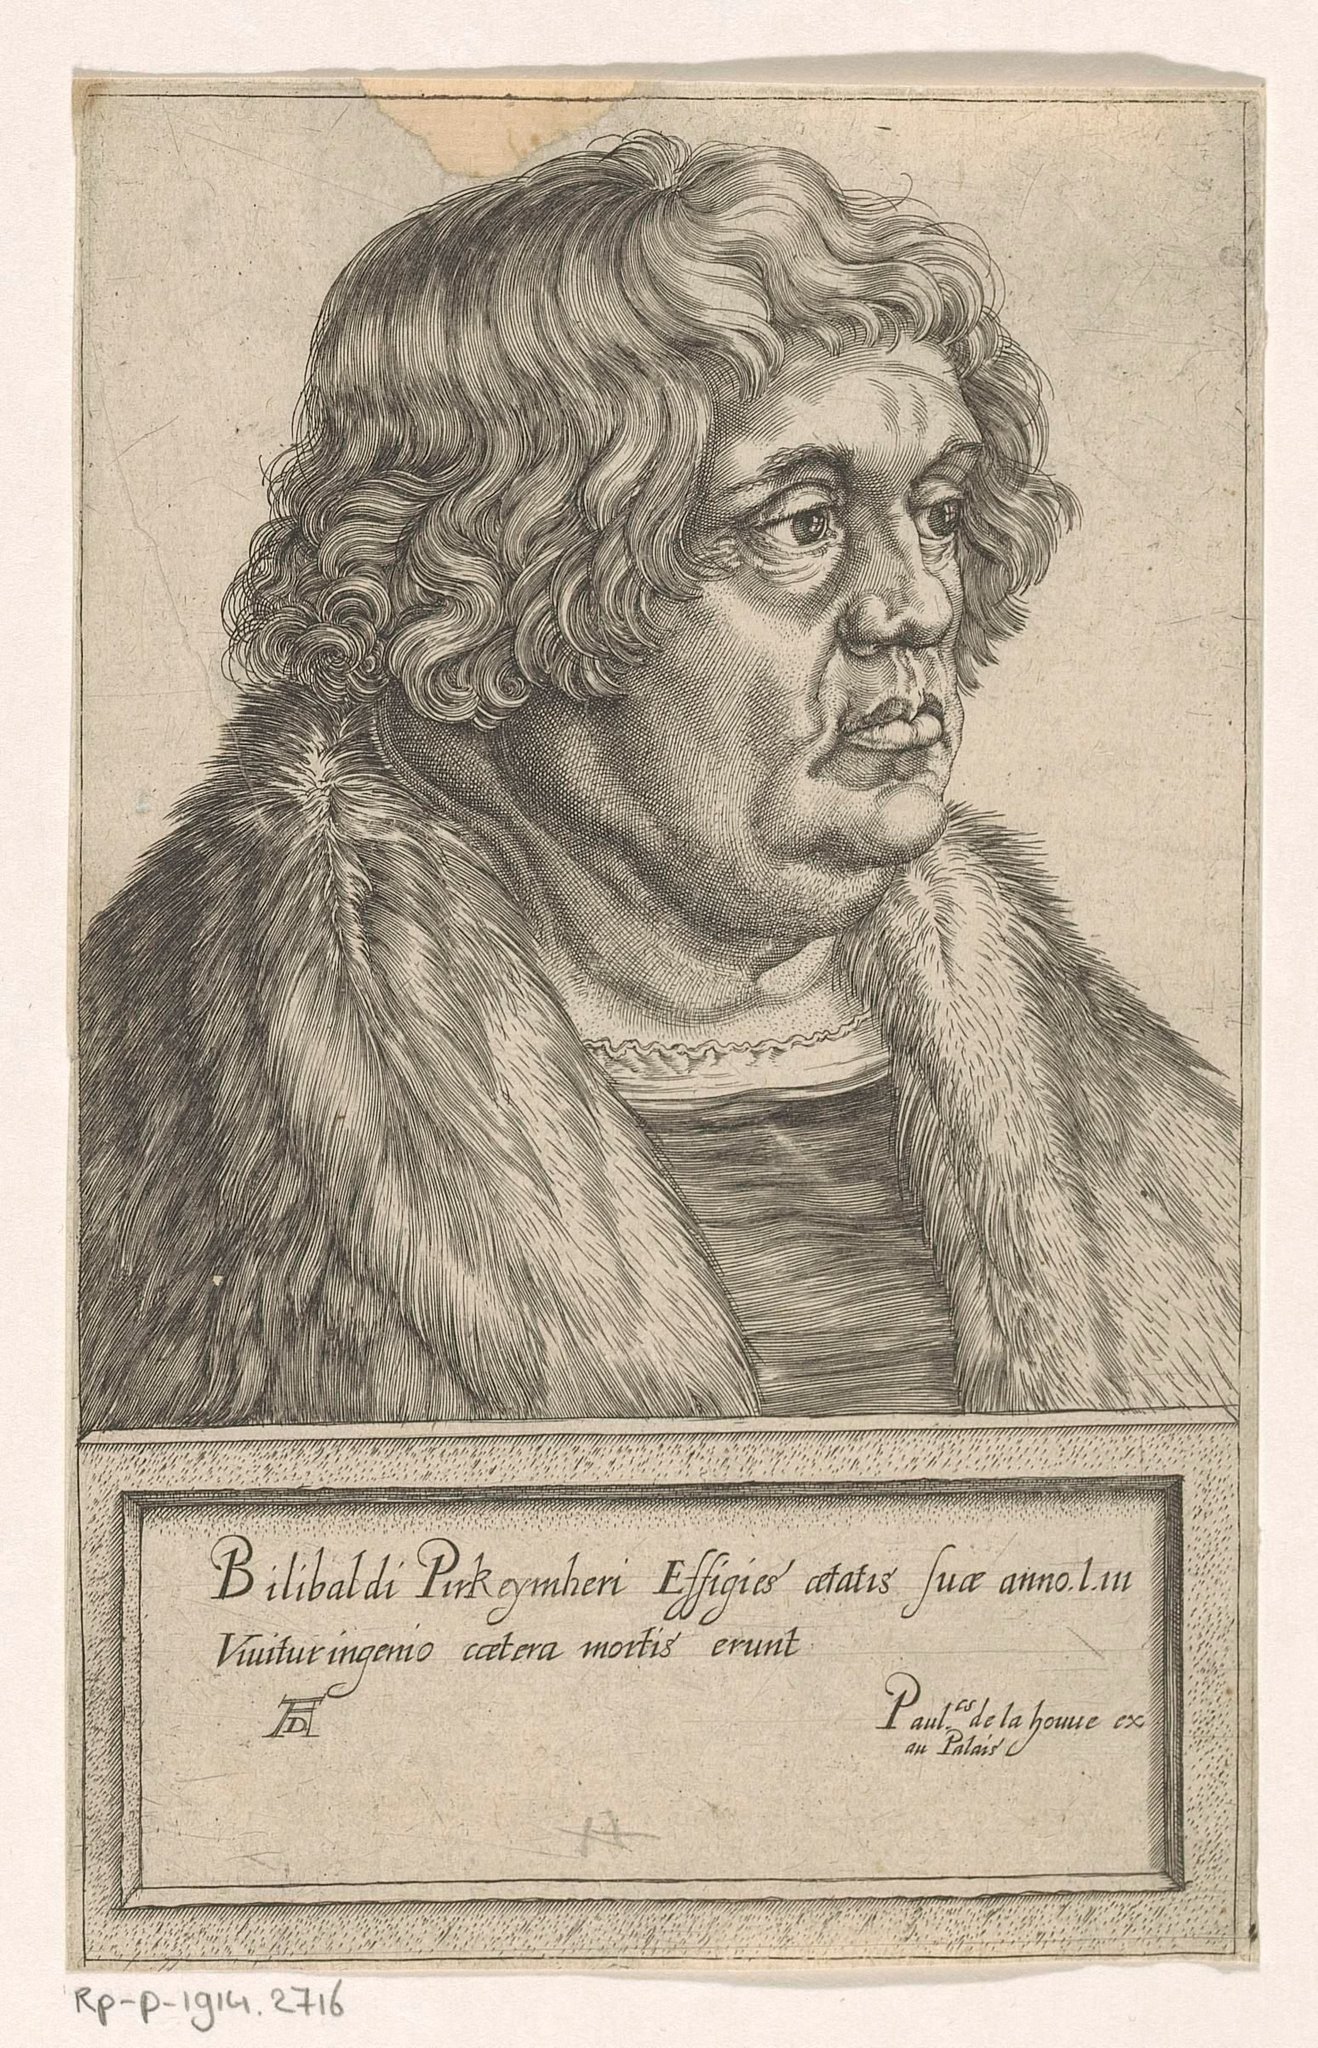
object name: print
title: Portret van Willibald Pirckheimer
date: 1600-1649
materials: paper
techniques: engraving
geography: france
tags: eichstätt, willibald pirckheimer, historical persons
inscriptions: collector's mark: Lugt 2228